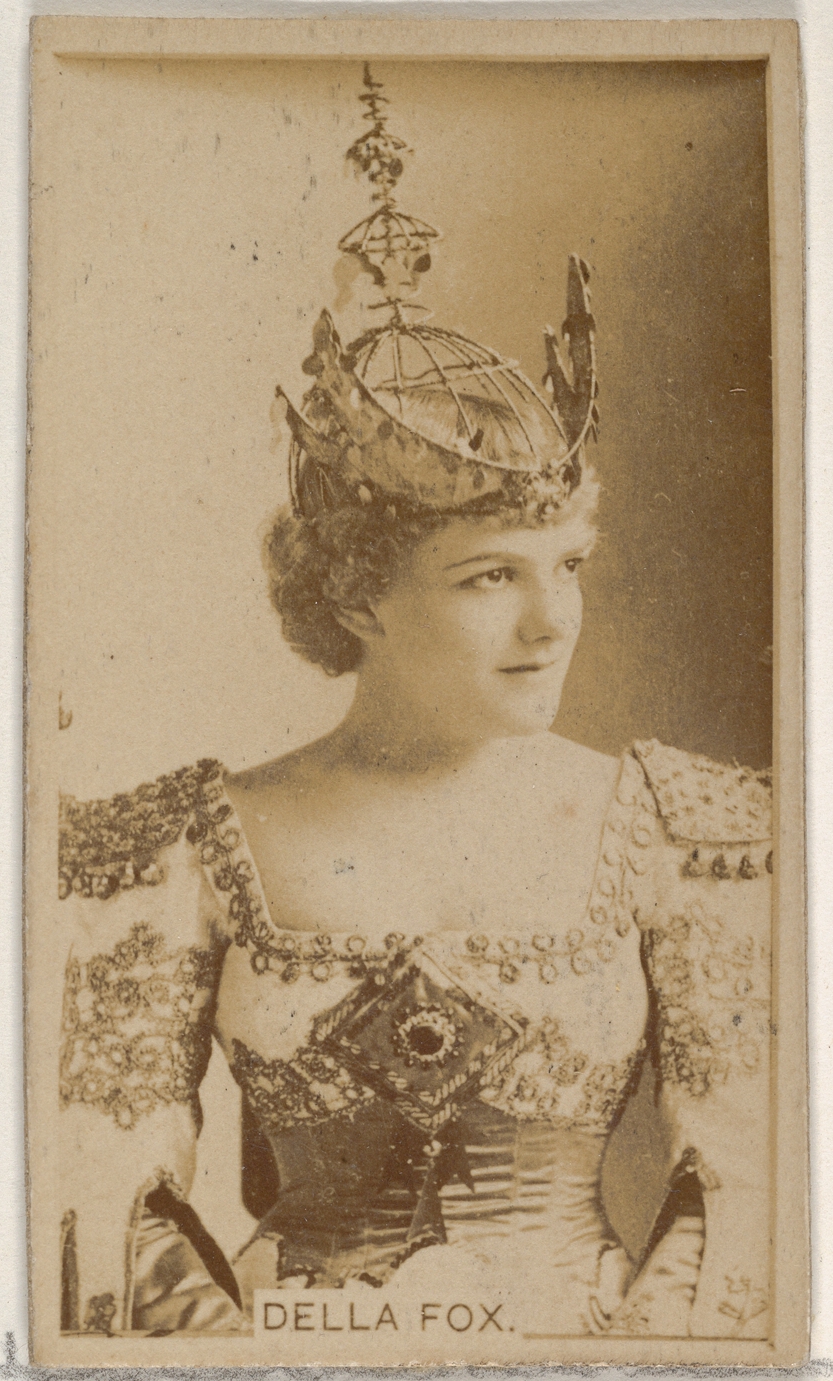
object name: photograph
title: Della Fox, from the Actors and Actresses series (N45, Type 8) for Virginia Brights Cigarettes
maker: allen & ginter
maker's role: publisher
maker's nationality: american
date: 1888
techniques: albumen silver print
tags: portraits,women,actresses